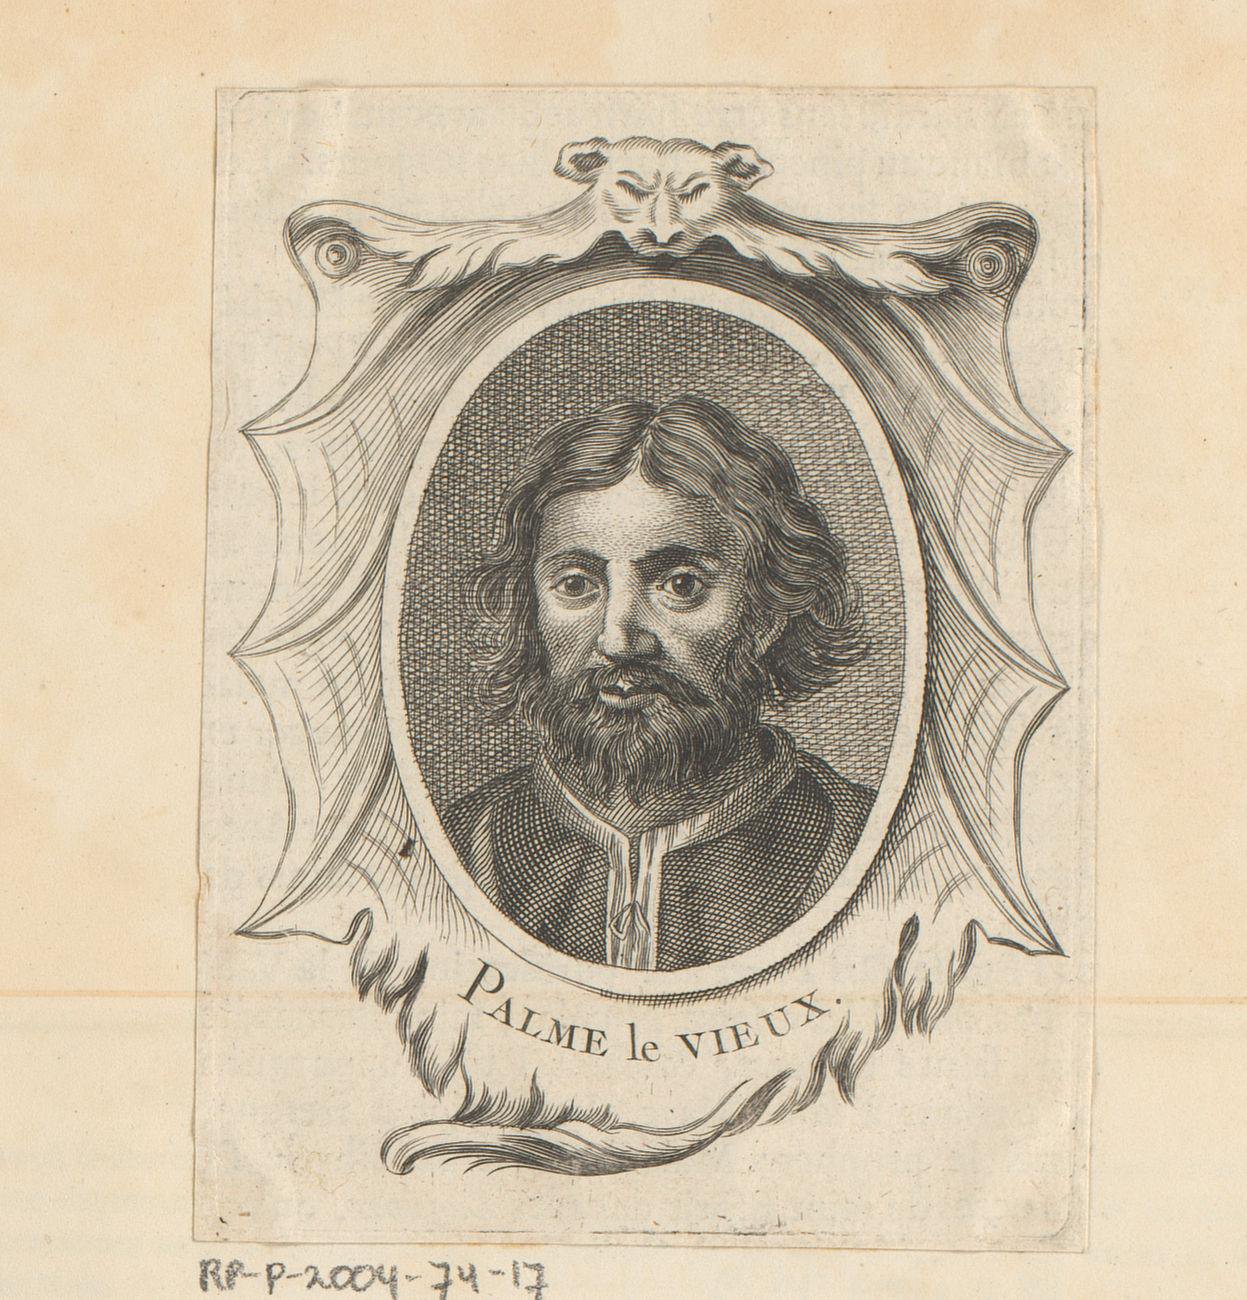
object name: album leaf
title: Portret van Jacopo Palma (il Vecchio)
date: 1745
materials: paper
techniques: engraving, letterpress printing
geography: paris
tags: venice, painter, draughtsman, jacopo palma (il vecchio), historical persons, portrait, self-portrait of painter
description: Prent uit: Dézallier d'Argenville, Antoine Joseph. Abrégé de la vie des plus fameux peintres. 4 dln. Parijs: De Bure l'aîné, 1745, dl. 1, p.190. De samensteller heeft deze prent in het album geplakt als illustratie bij: Pilkington, Matthew en Johann Heinrich Füssli. A dictionary of painters, from the revival of the art to the present period. 4 dln. Londen: John Crowder, 1805, dl. 3, p. 380.